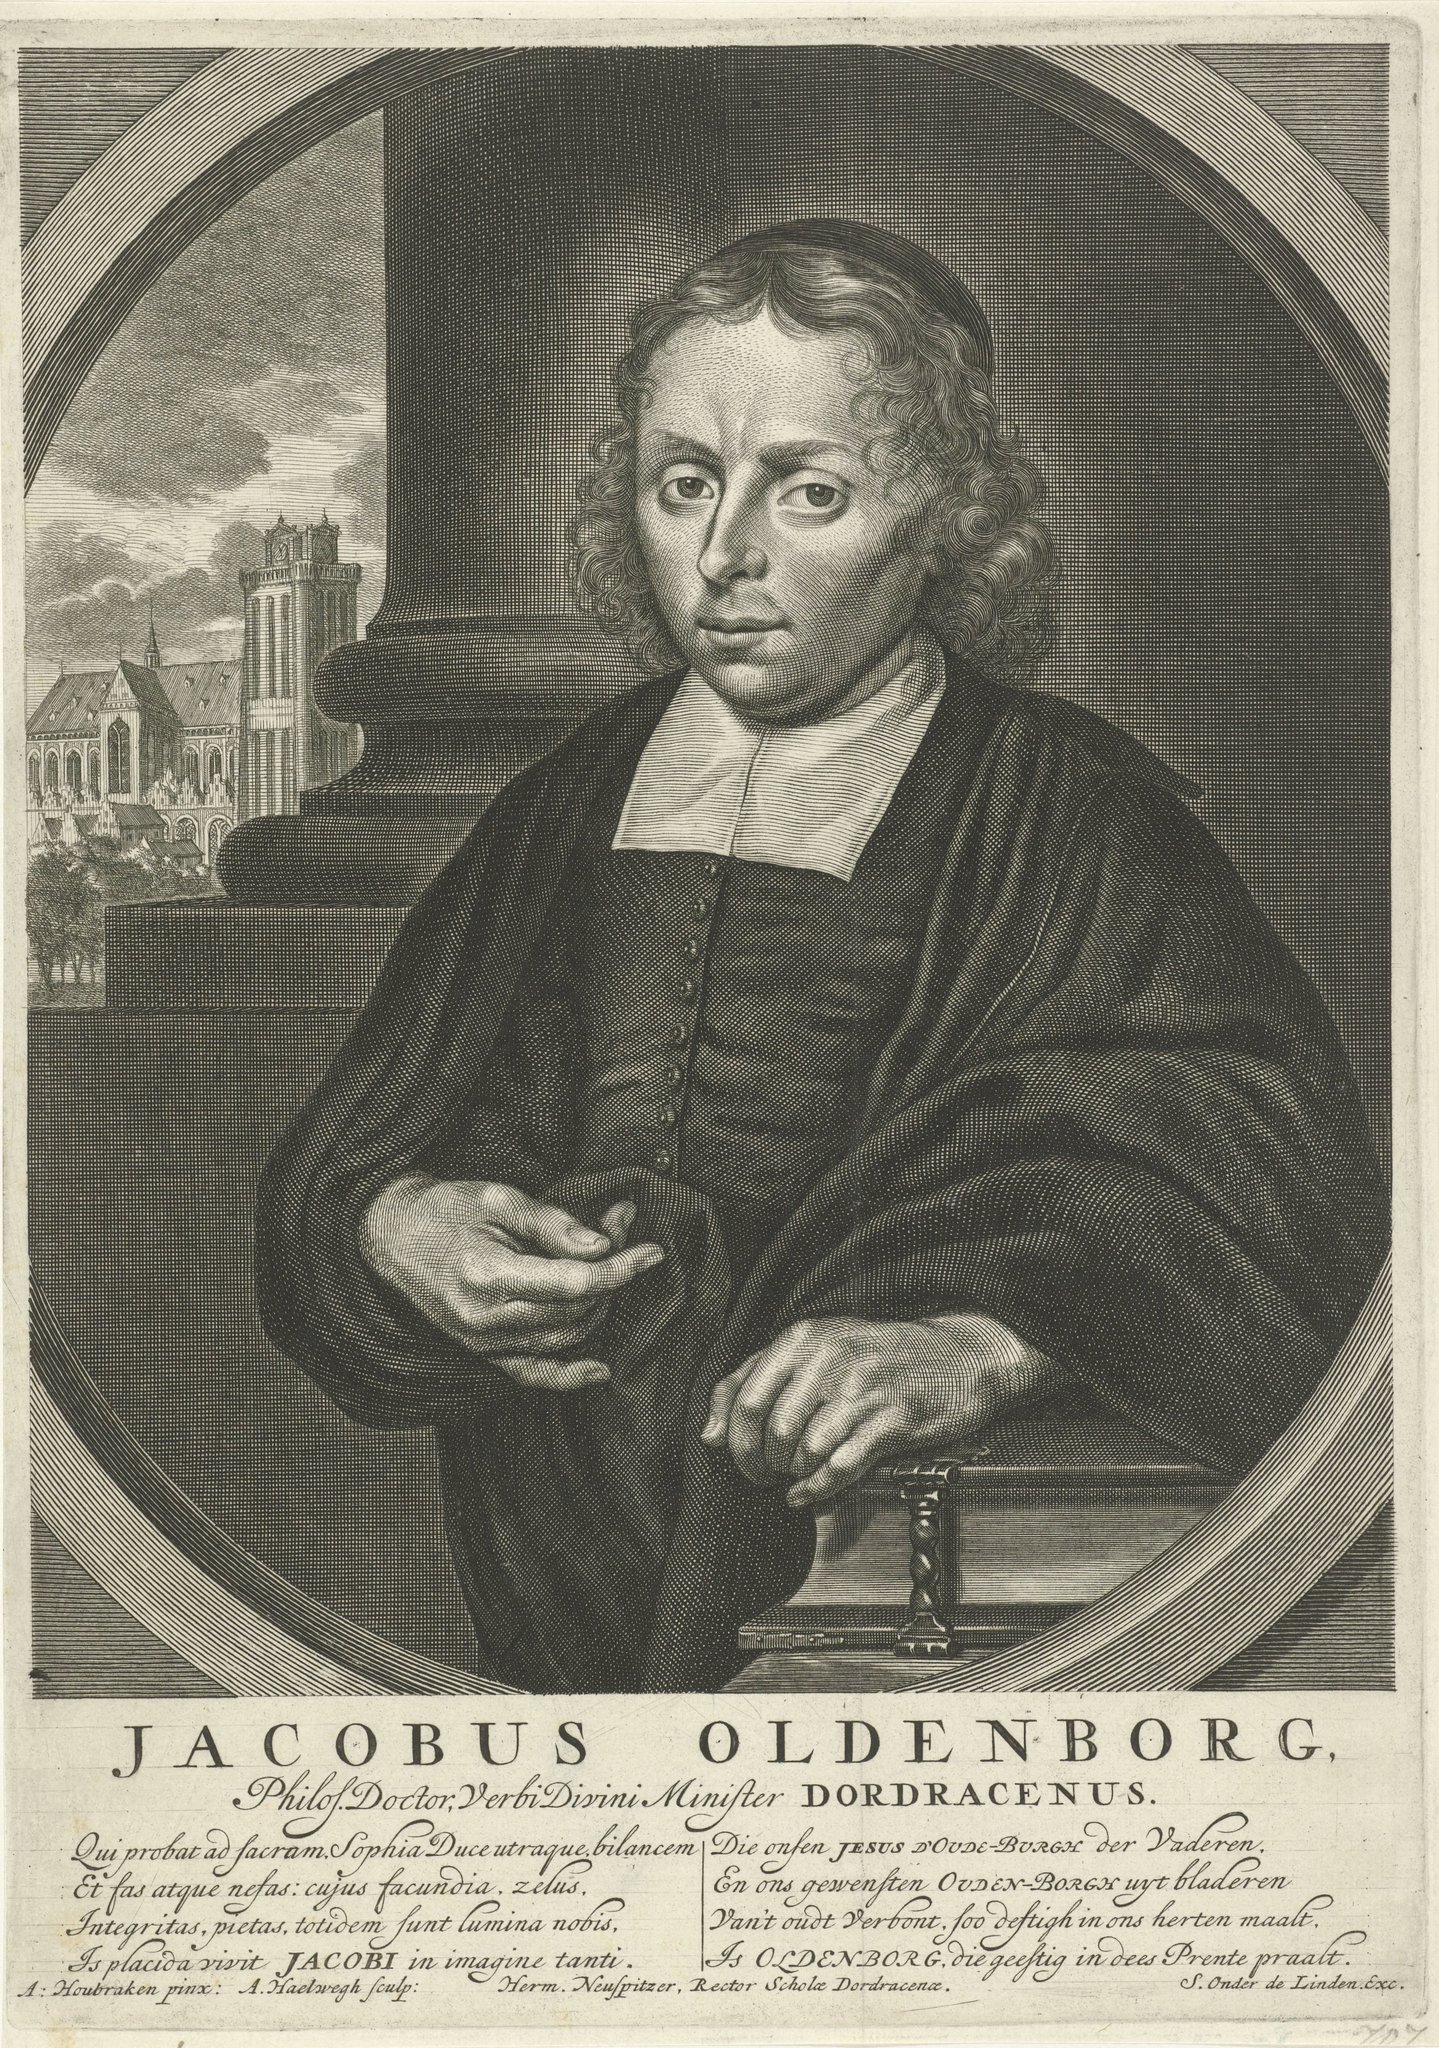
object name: print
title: Portret van Jacobus van Oldenburg, predikant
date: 1682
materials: paper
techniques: engraving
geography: amsterdam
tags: dordrecht, parts of church exterior and annexes: tower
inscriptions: collector's mark: Lugt 2228